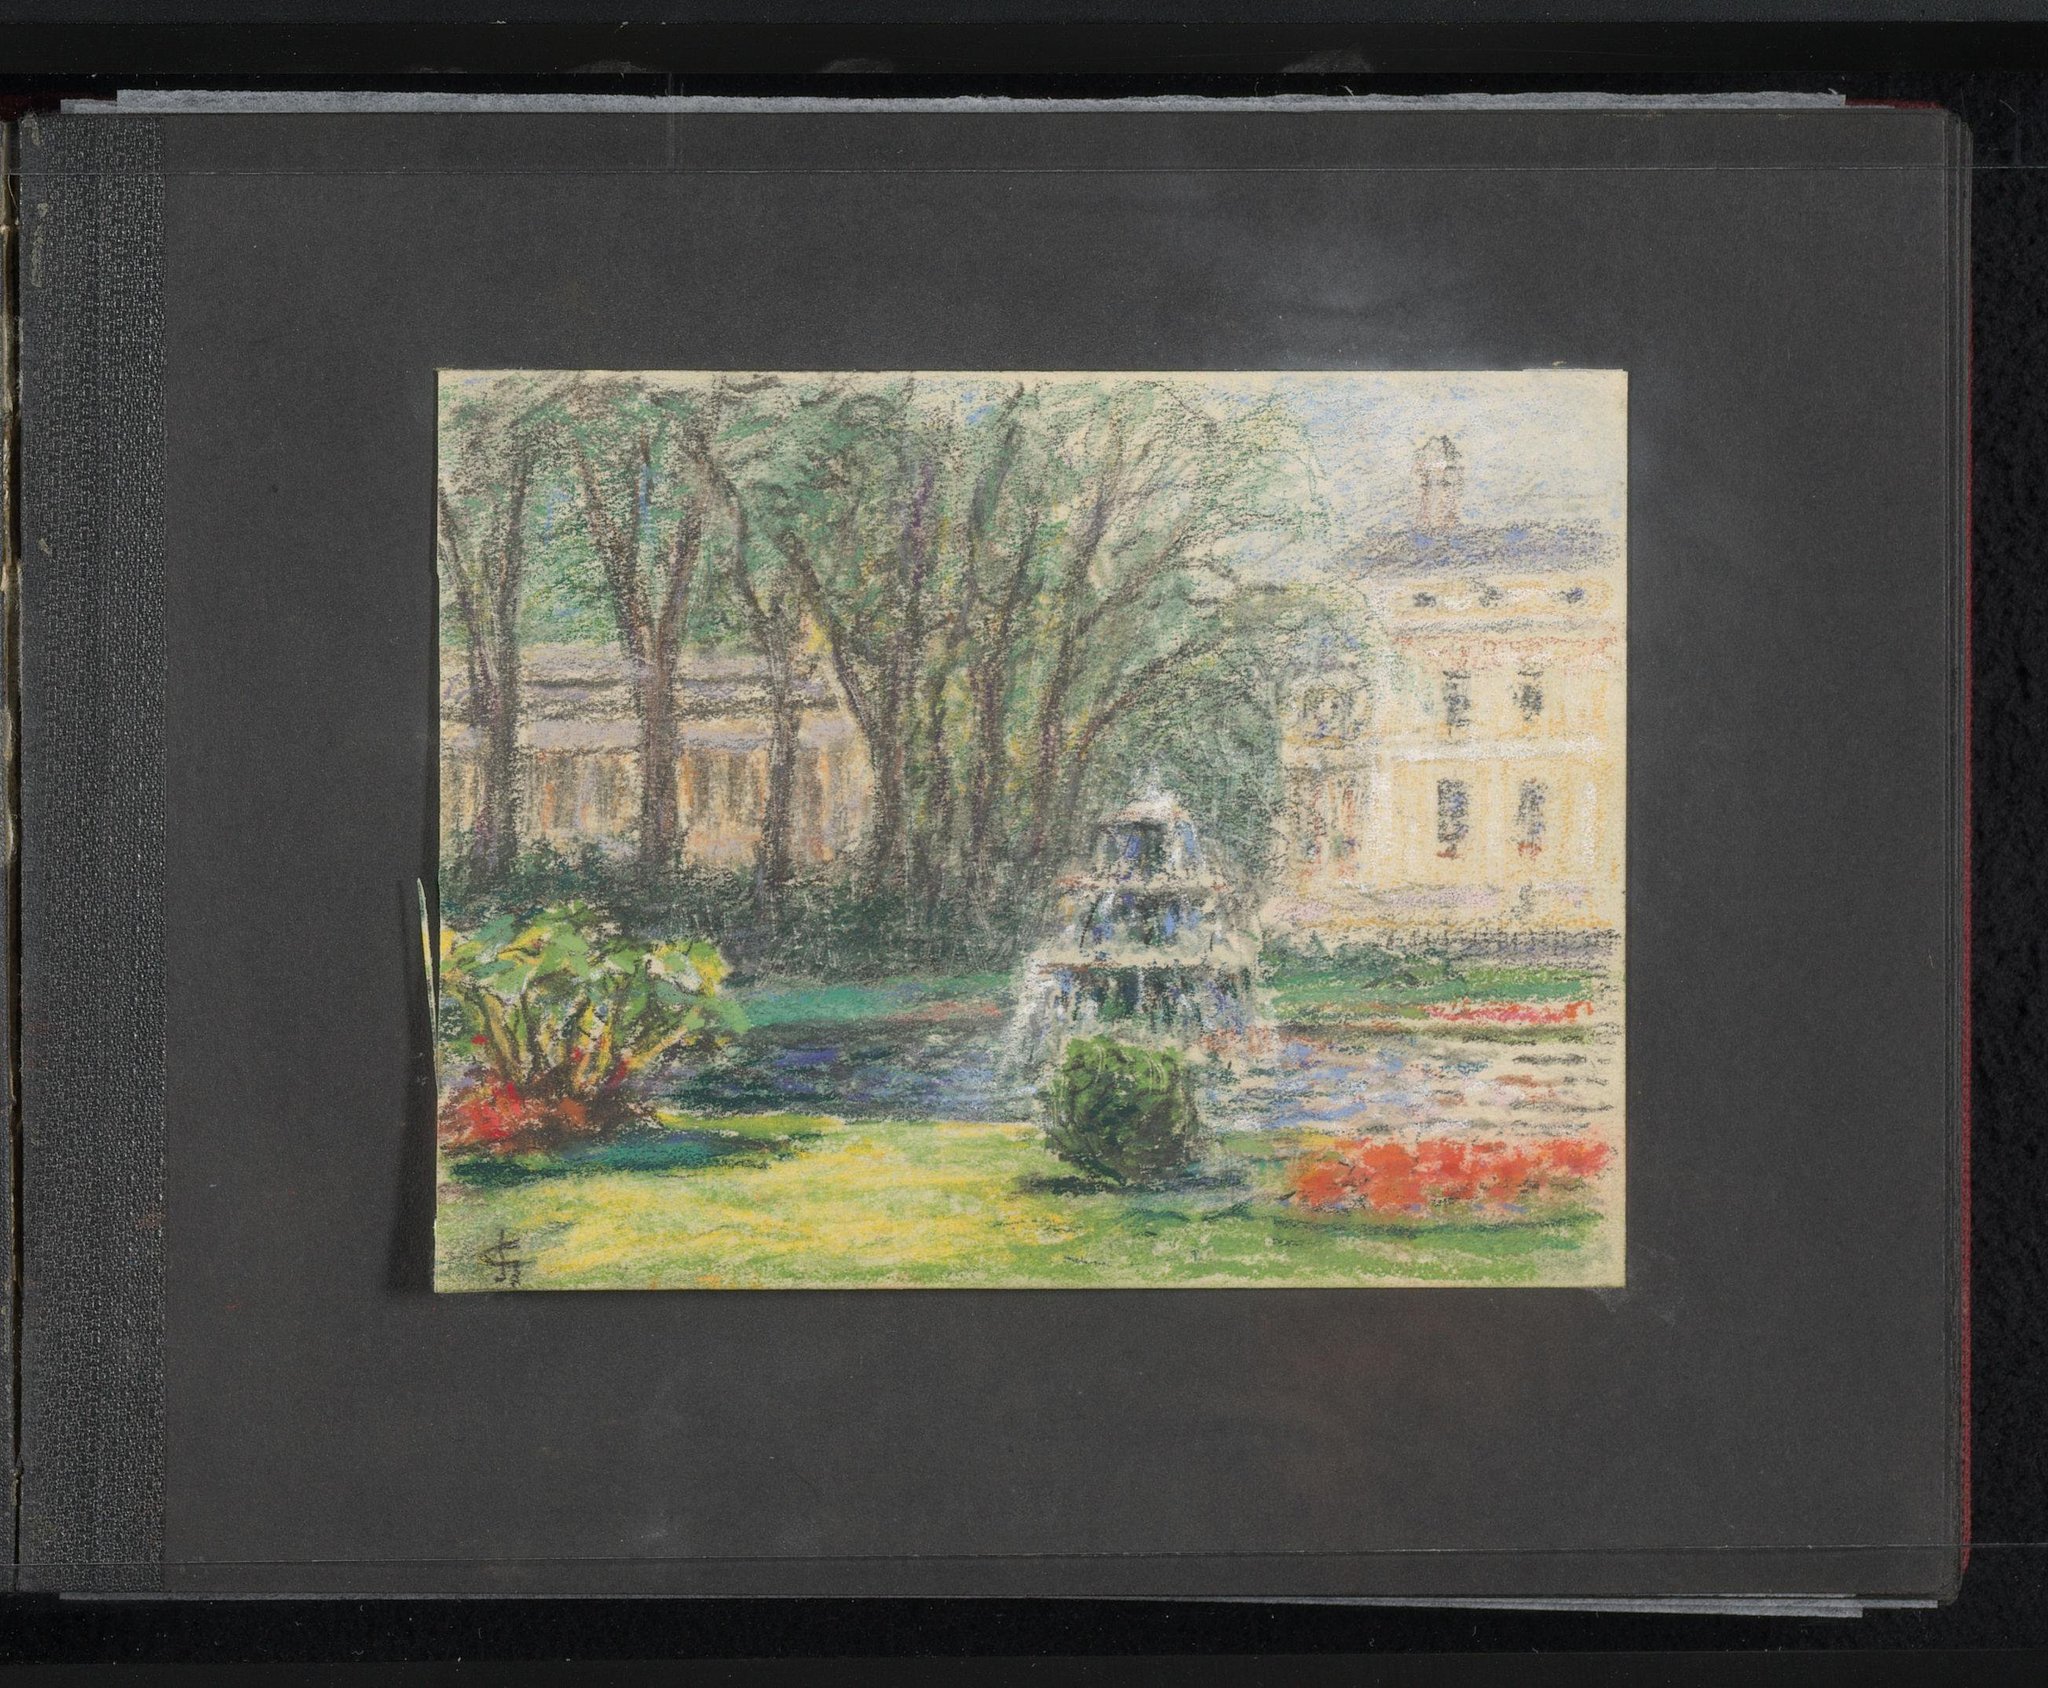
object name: drawing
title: Park met bomen, bloemen en vijver met fontein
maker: carel nicolaas storm van s-gravesande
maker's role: draughtsman, print maker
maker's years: 1841-1924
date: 1915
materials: chalk, paper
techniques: pasting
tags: flowers, trees, garden fountain, public gardens, park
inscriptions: inscription: ‘Wiesbaden Bon[...]/ 1915’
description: Mogelijk bij het Kurhaus te Wiesbaden. Tekening maakt deel uit van een album.